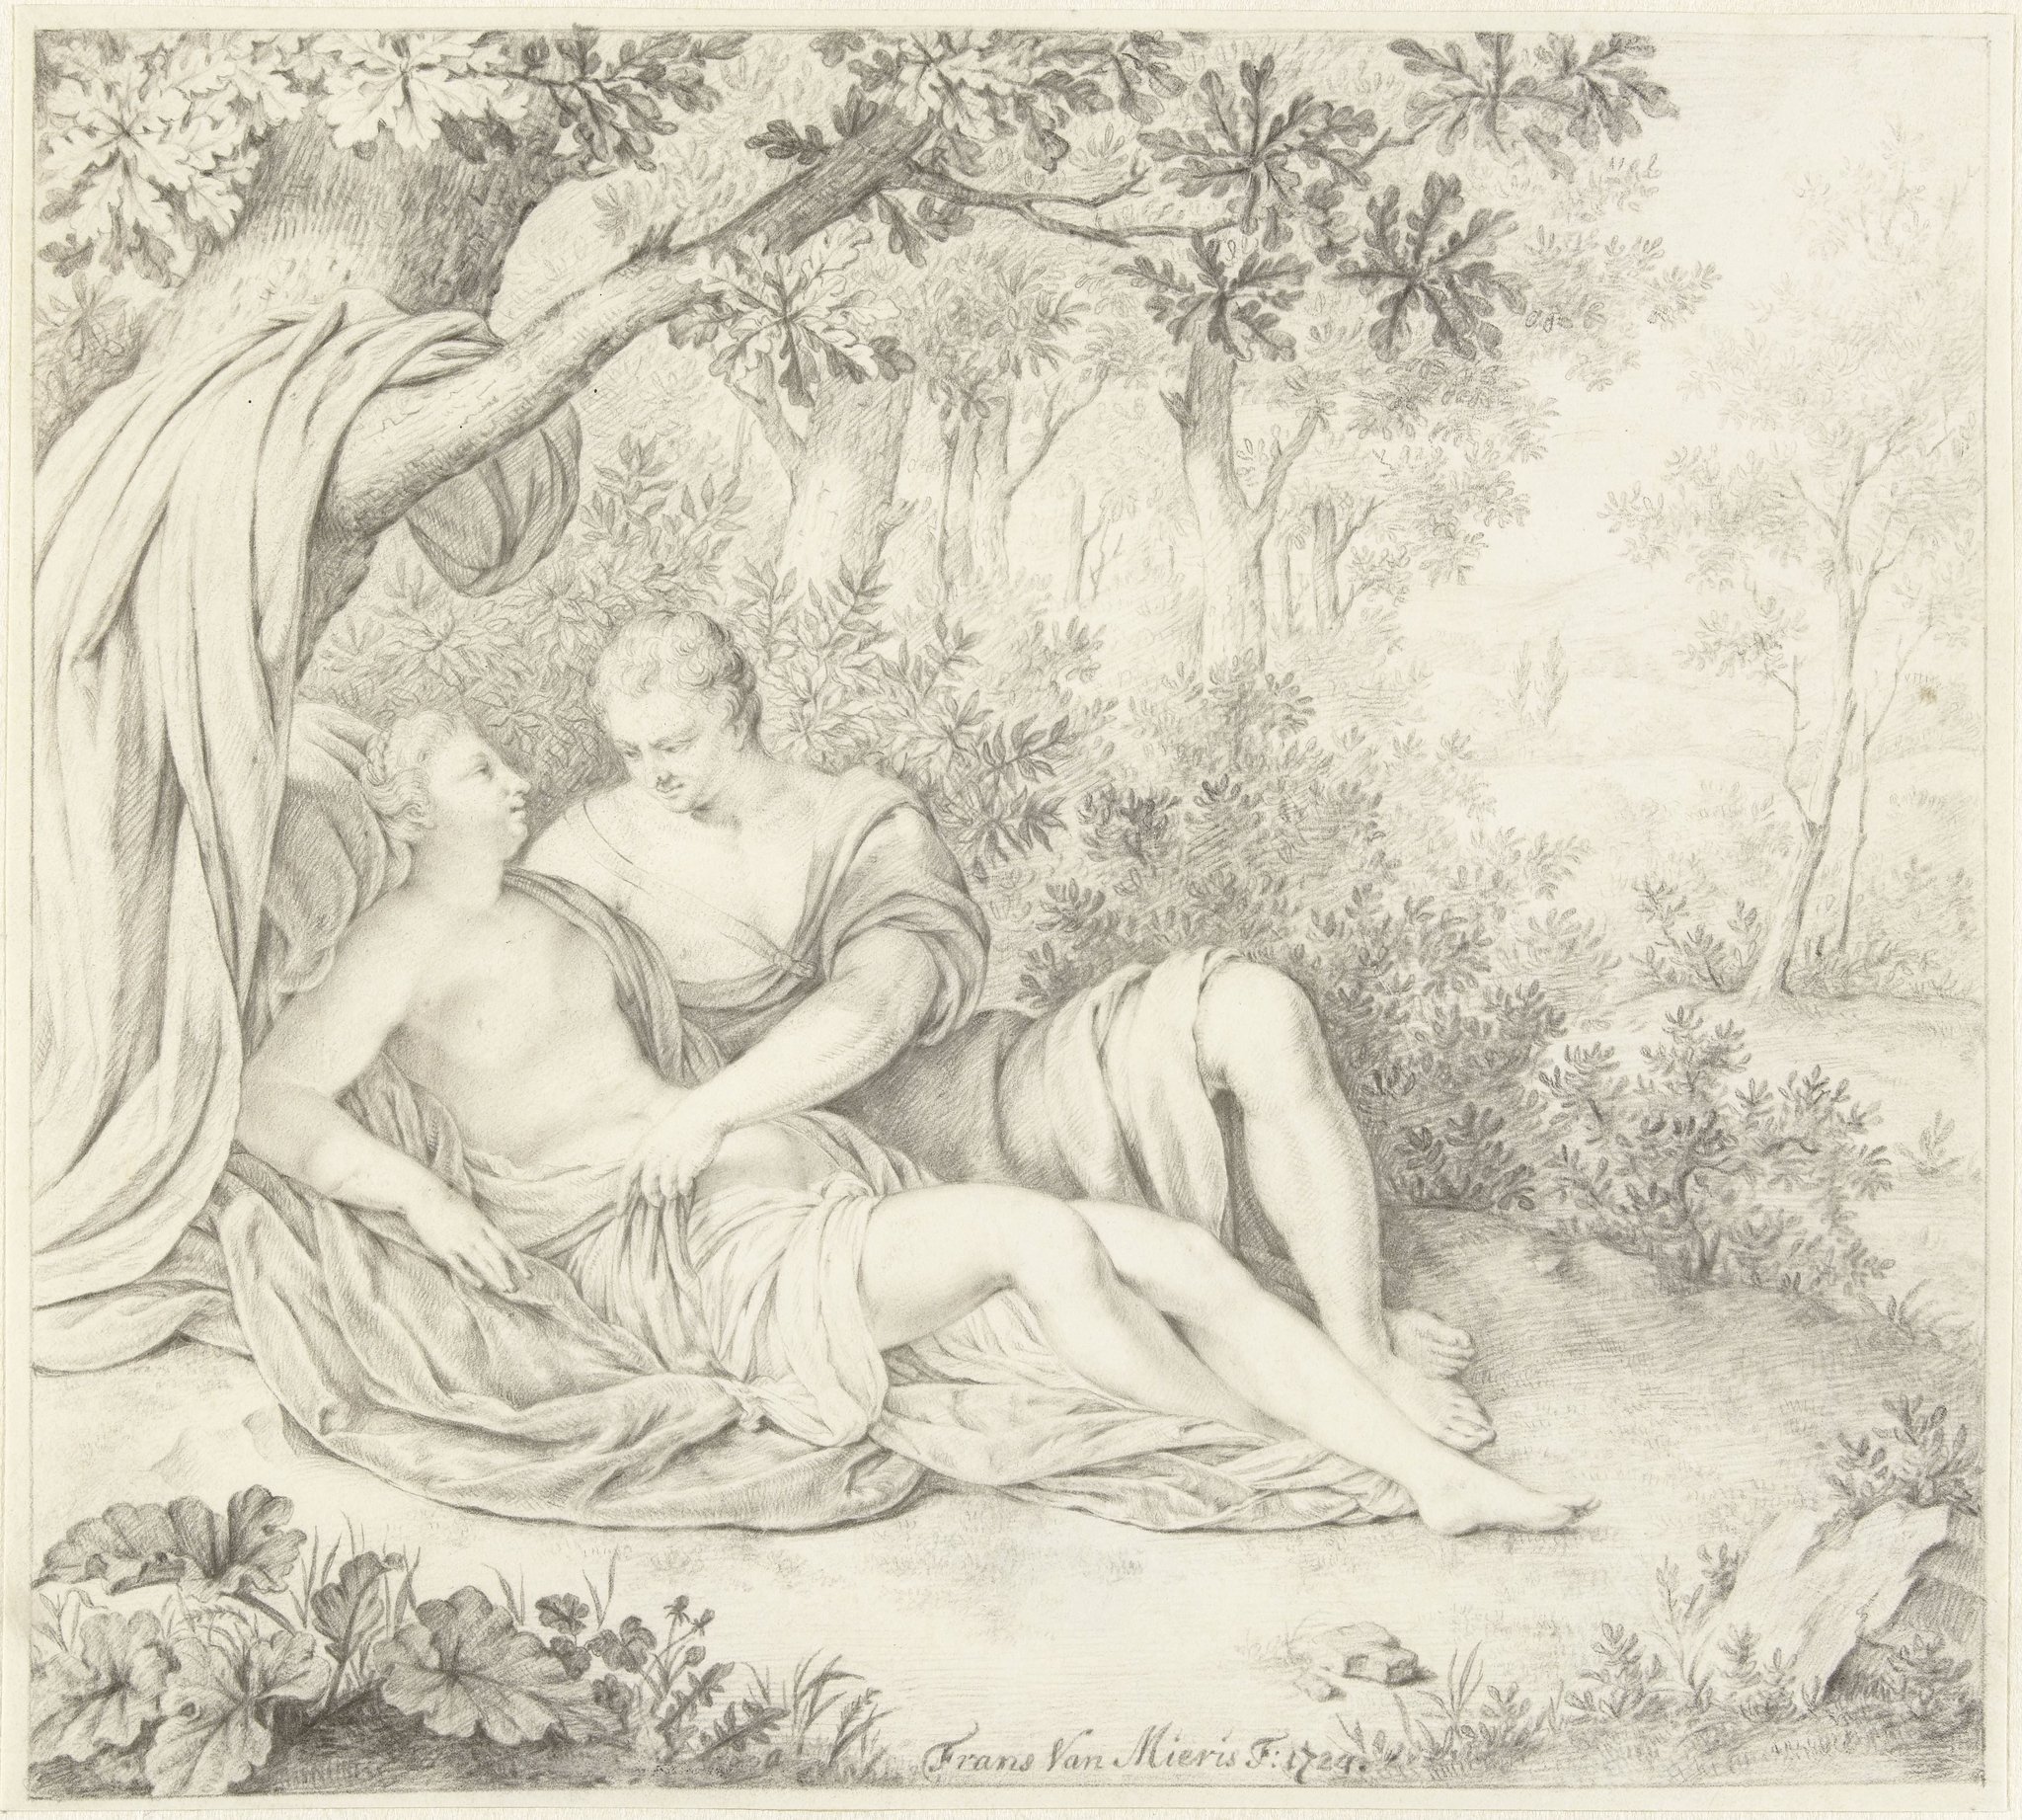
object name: drawing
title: Liefdespaar onder boom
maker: frans van mieris (ii)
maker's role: draughtsman, painter, print maker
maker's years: 1689-1763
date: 1724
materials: chalk, parchment, pencil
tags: couple of lovers